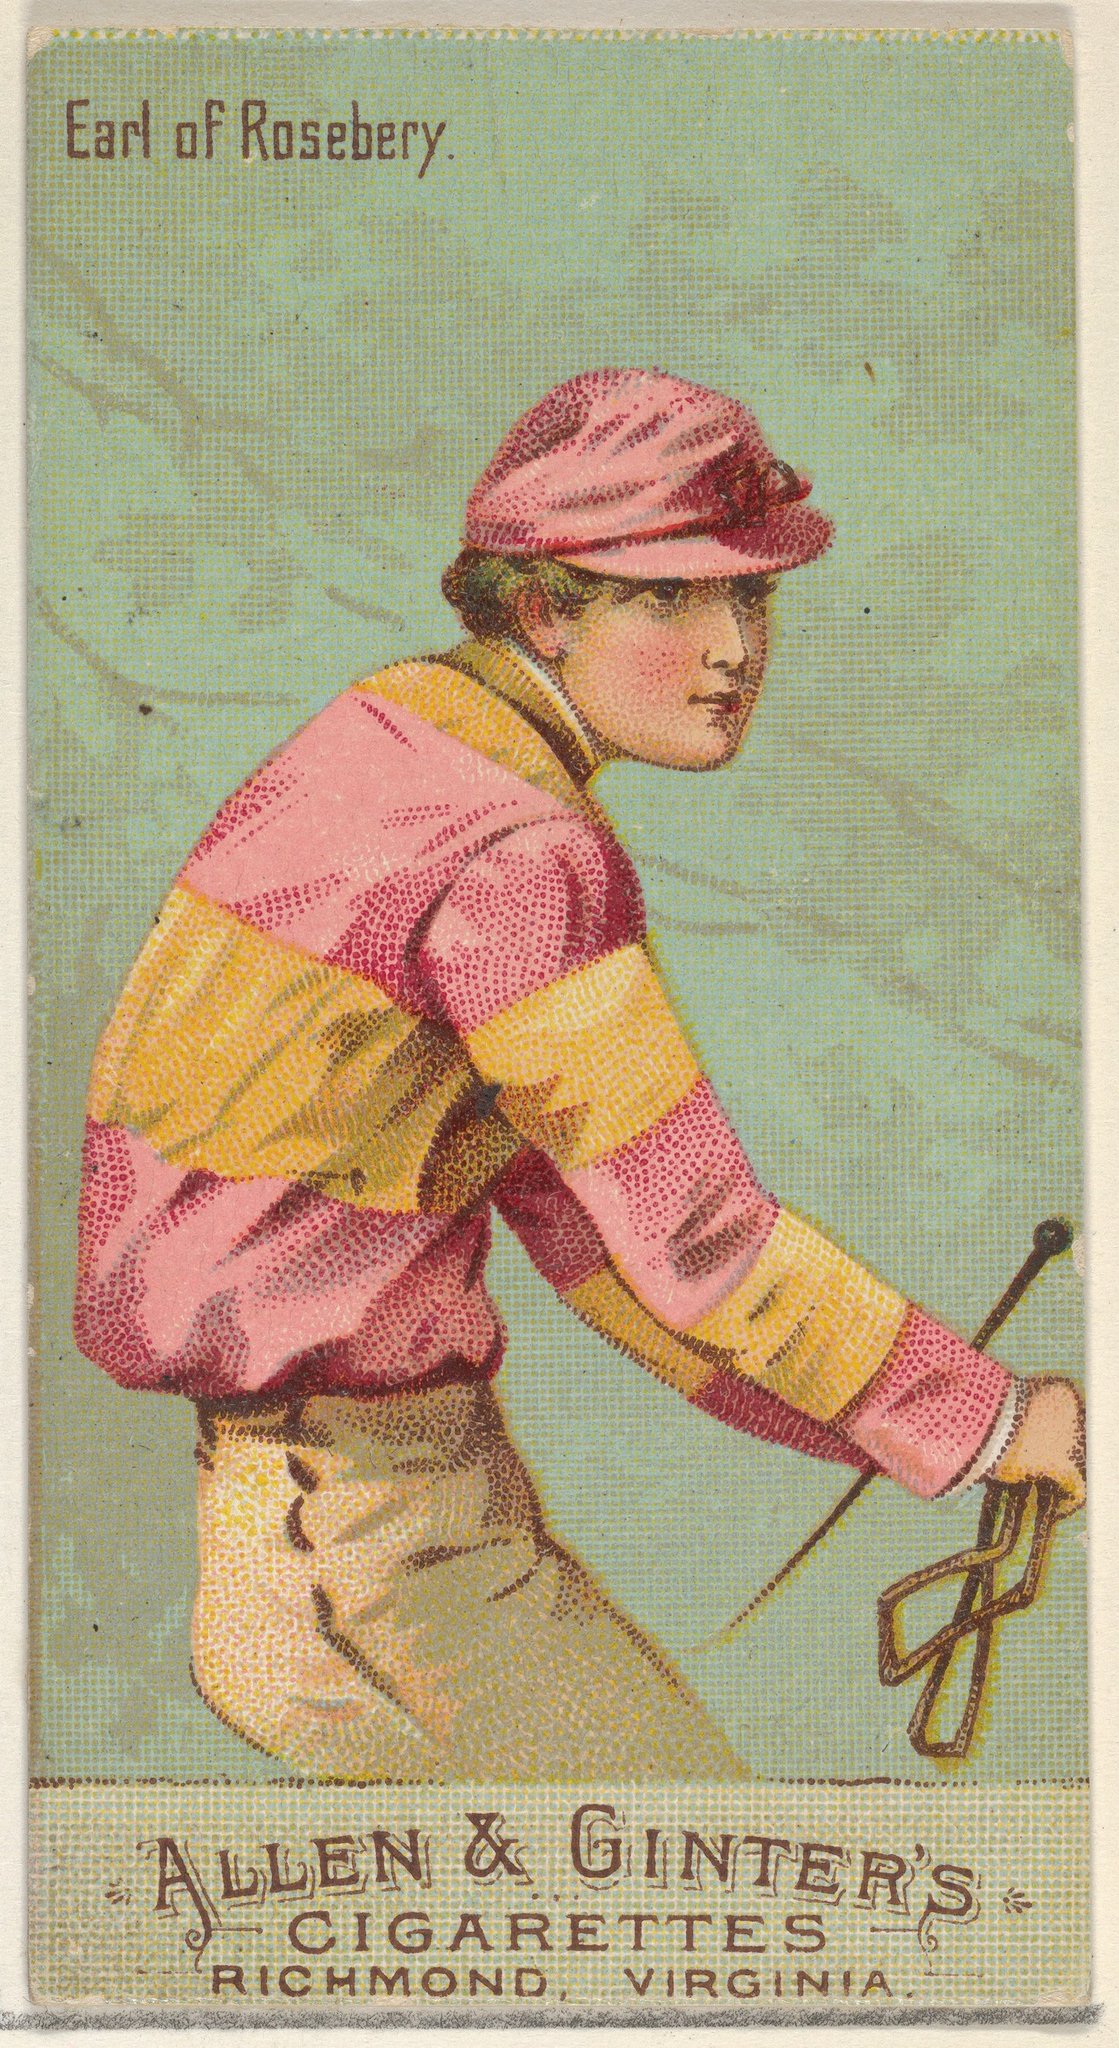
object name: print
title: Duke of Rosebery, from the Racing Colors of the World series (N22b) for Allen & Ginter Cigarettes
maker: allen & ginter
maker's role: publisher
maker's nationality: american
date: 1888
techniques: color lithograph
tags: women,jockeys